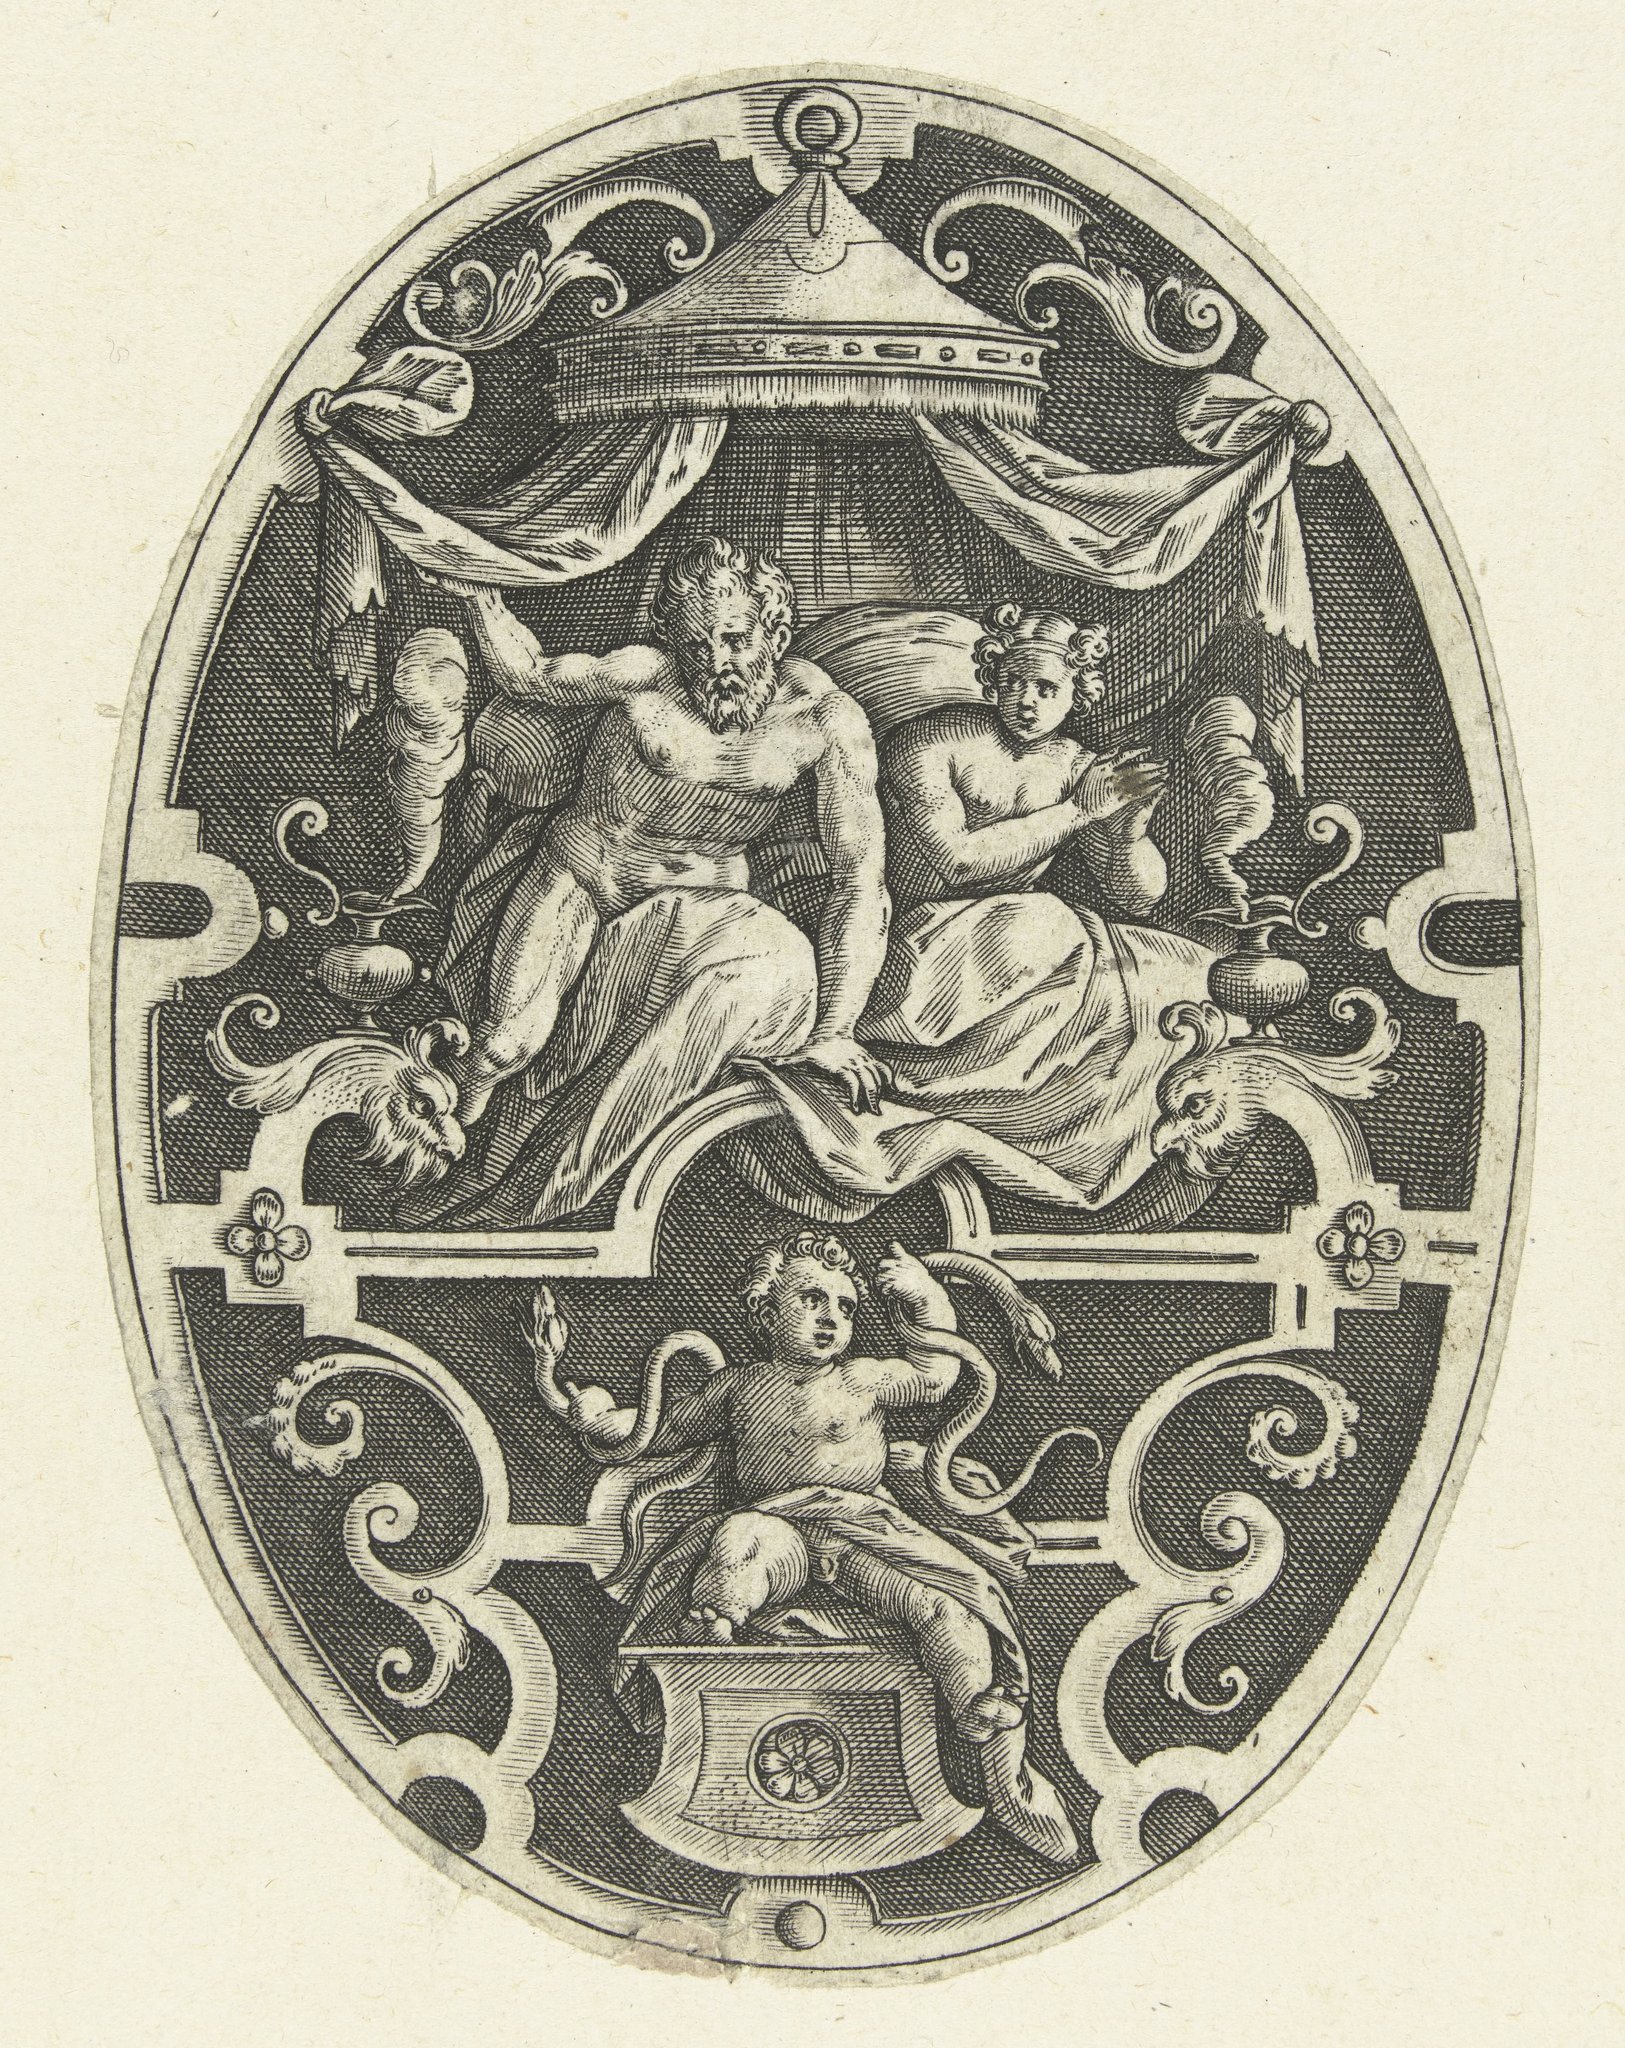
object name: ornament print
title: Ovale vlakdecoraties met de daden van Hercules in grotesken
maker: gerard de jode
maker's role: draughtsman, print maker, publisher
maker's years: 1508-1591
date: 1519-1591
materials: paper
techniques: engraving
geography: netherlands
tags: hercules strangles two serpents in his cradle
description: Een van 9 bladen afkomstig uit een serie van 12. Gearceerde achtergrond.